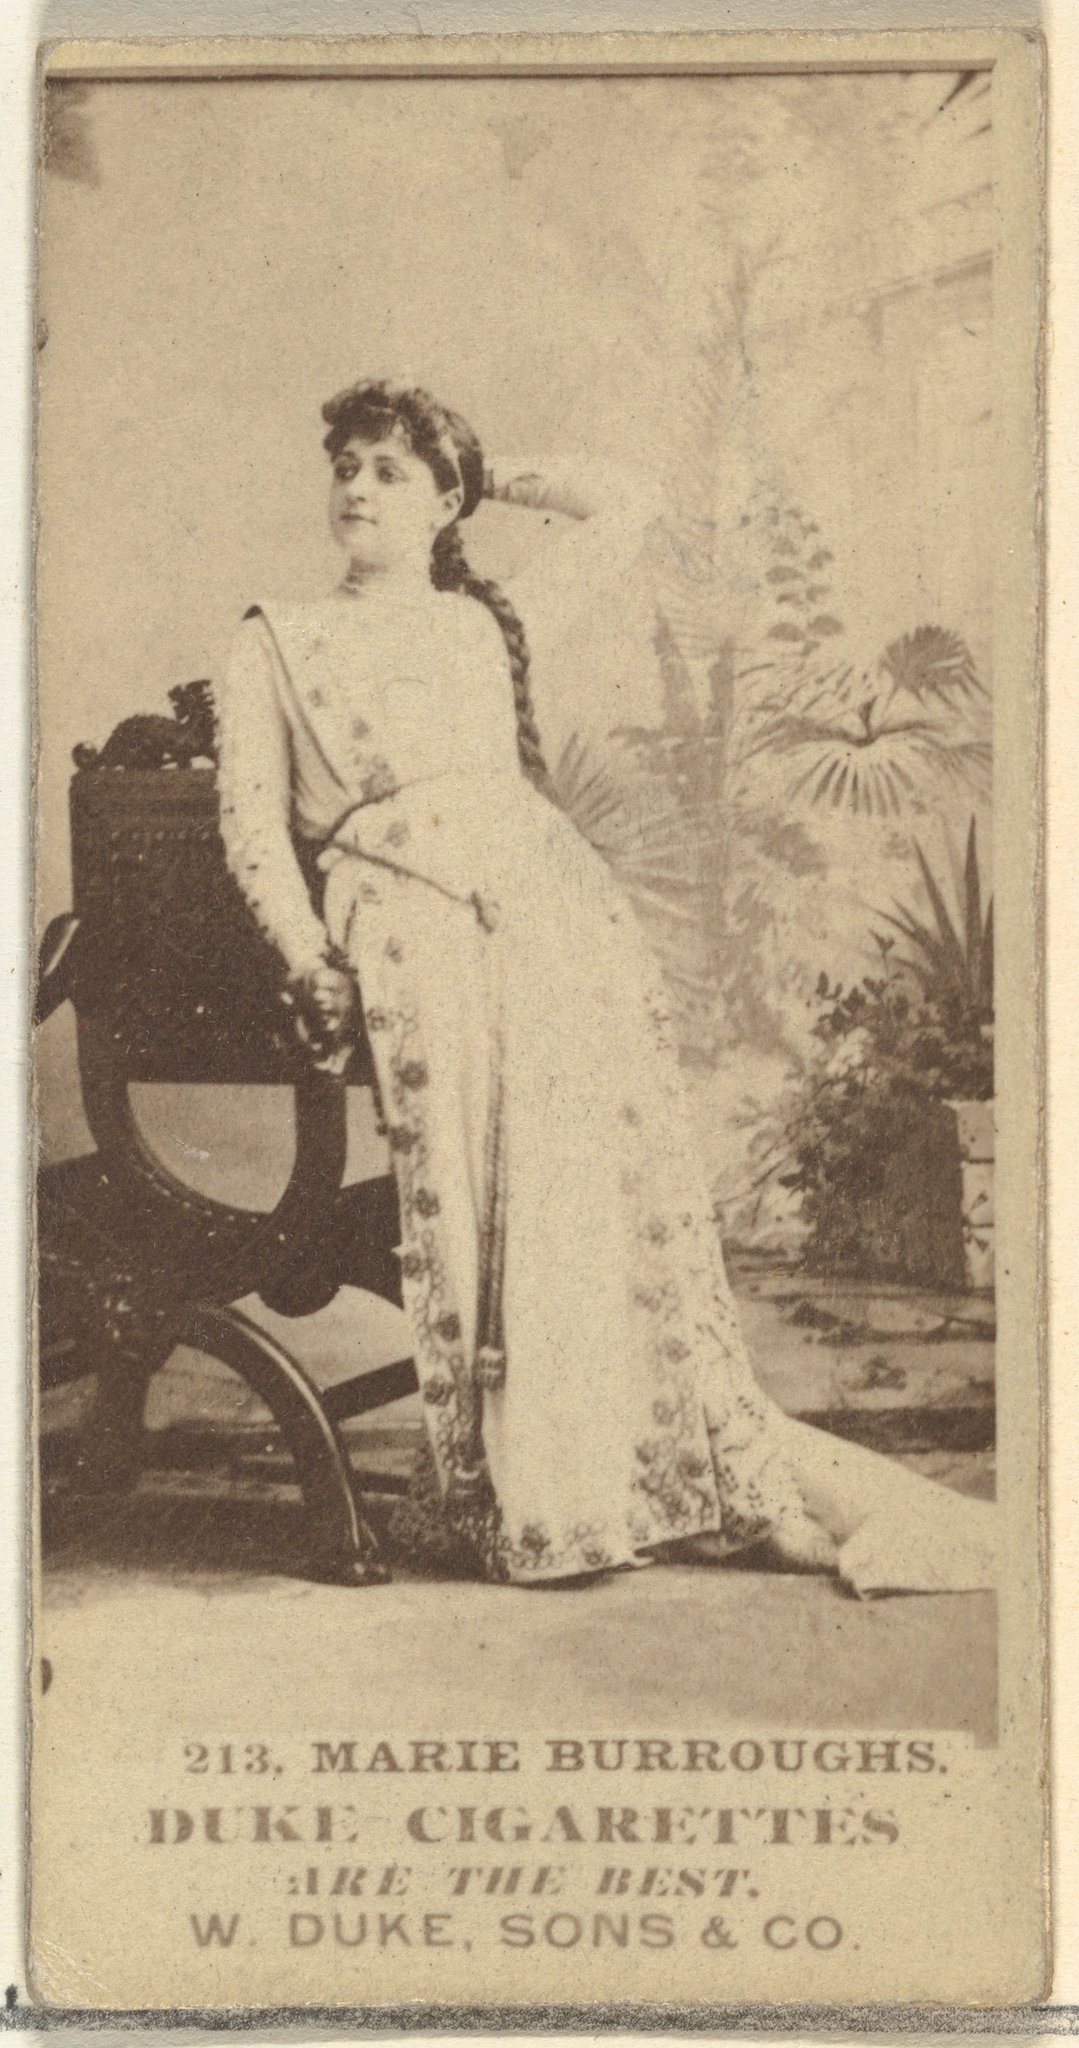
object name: photograph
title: Card Number 213, Marie Burroughs, from the Actors and Actresses series (N145-7) issued by Duke Sons & Co. to promote Duke Cigarettes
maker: w. duke, sons & co.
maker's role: publisher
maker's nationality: american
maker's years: 1870-1920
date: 1880-1889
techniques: albumen silver print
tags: portraits,women,actresses